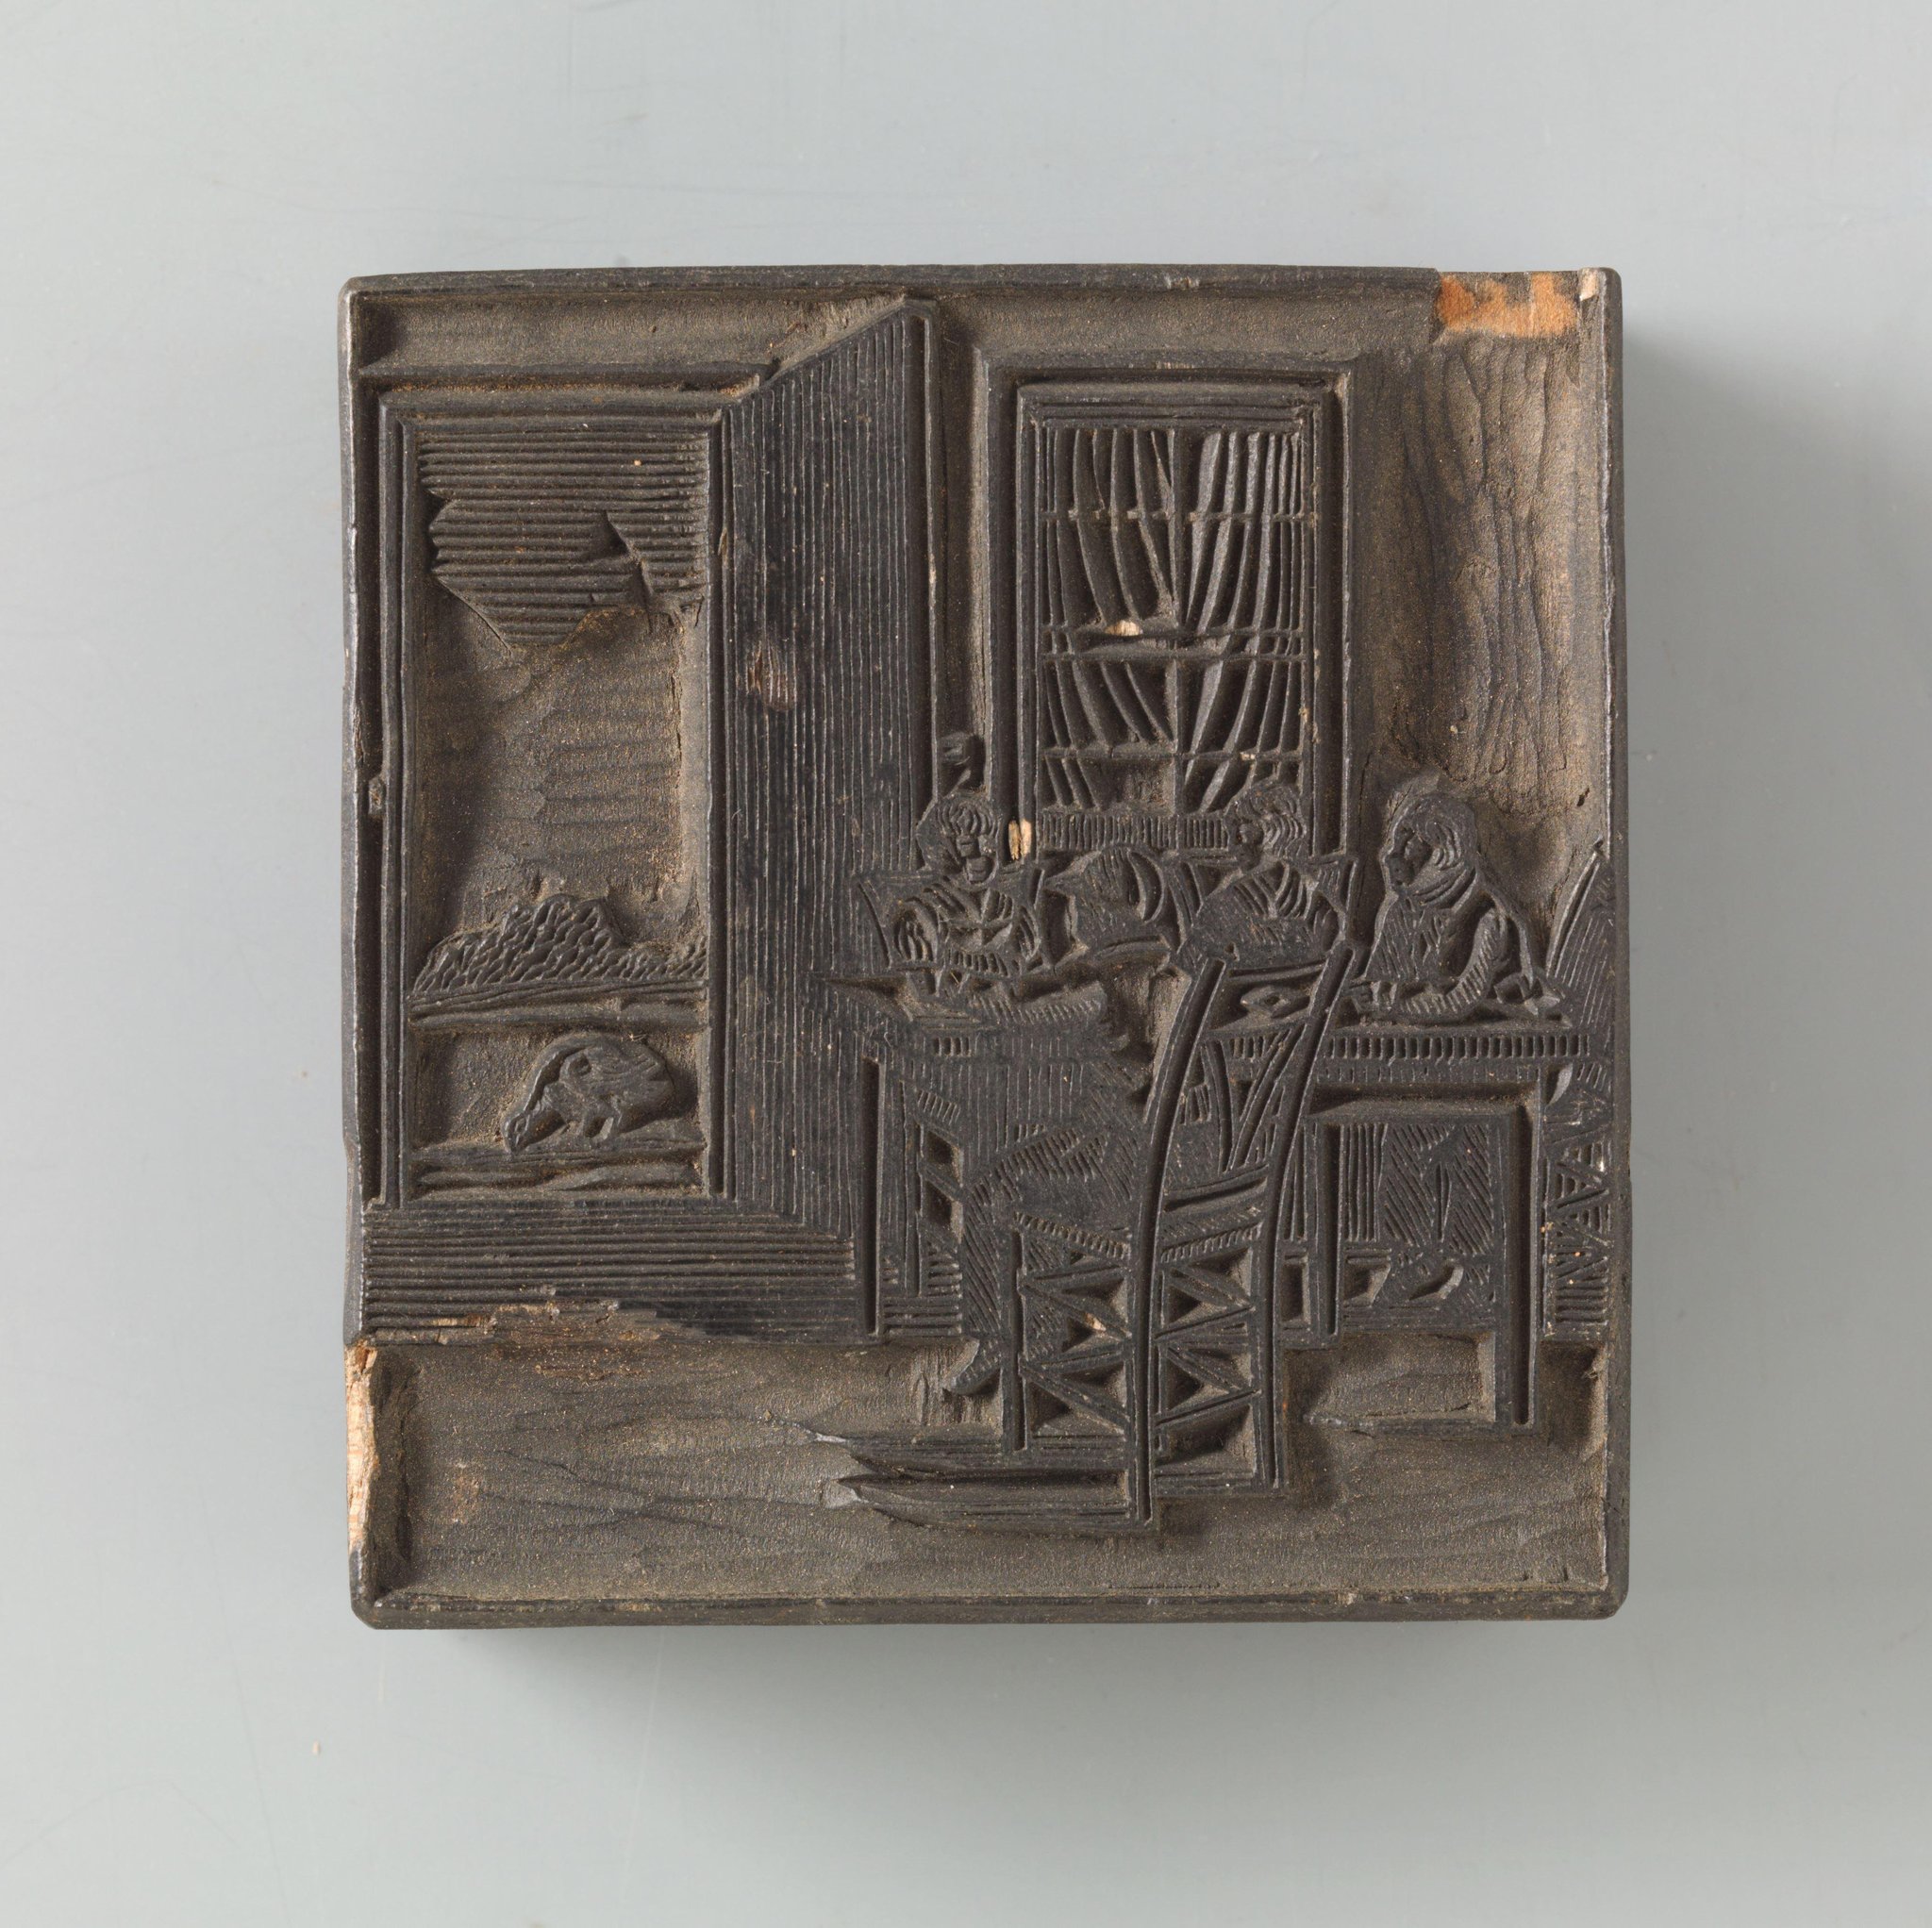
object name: wood block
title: Vier kinderen aan een tafel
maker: Anonymous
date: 1700-1899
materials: wood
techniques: woodcut